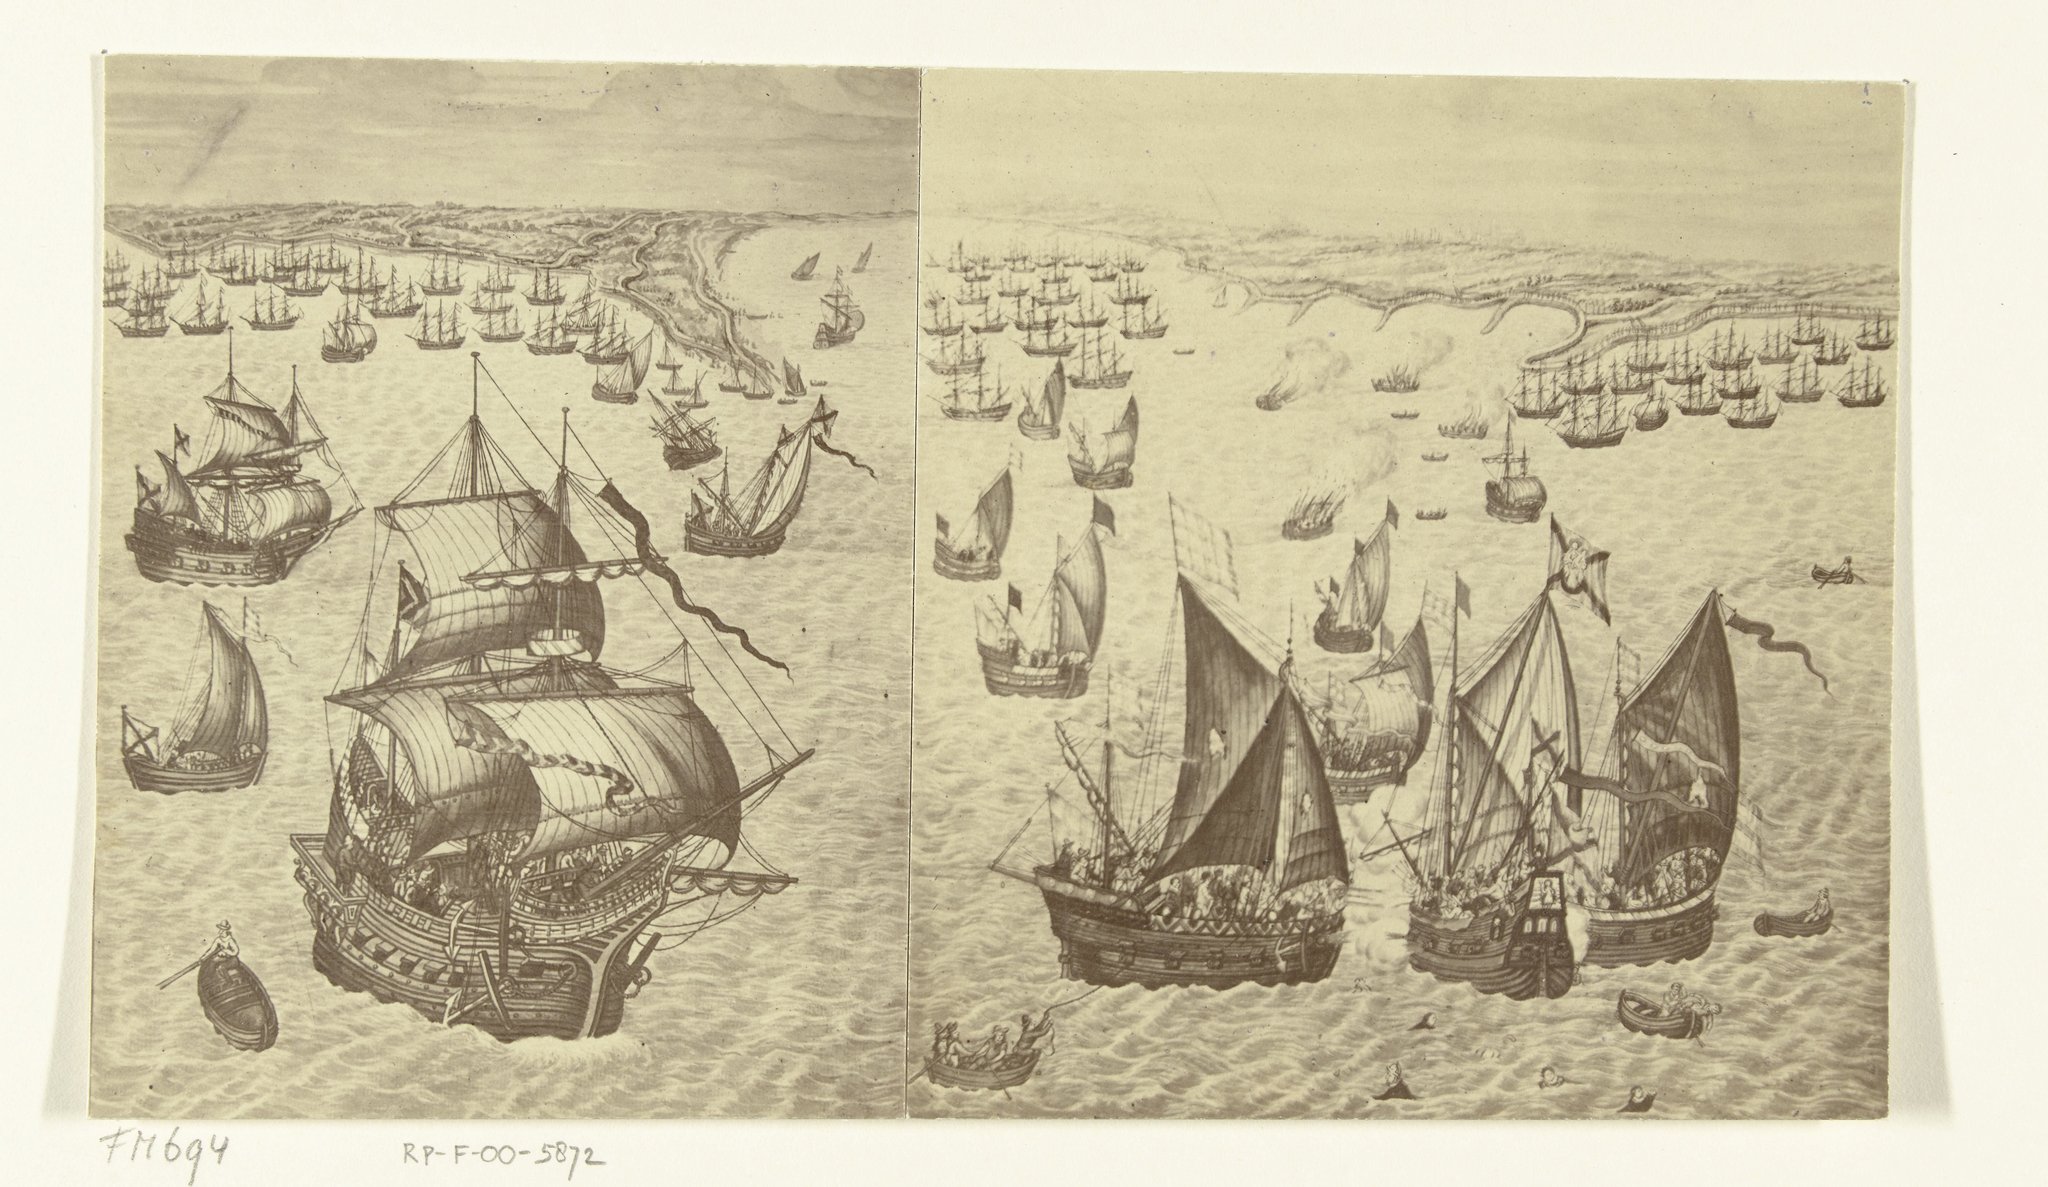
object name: photograph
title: Wandtapijt met de schermutselingen bij Den Haak, 1572-1573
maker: j. v.d. graft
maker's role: fotograaf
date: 1863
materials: photographic support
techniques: albumen print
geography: middelburg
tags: battle (+ naval force), tapestry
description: Foto van de twee wandtapijten geweven door Hendrick de Maecht te Middelburg naar ontwerp van Hendrick Vroom te Haarlem en patroonschilder Huybrecht Leyniers te Dordrecht in de jaren 1600-1603. Het tapijt bevindt zich in de collectie van het Zeeuws Museum te Middelburg. Het onderwerp van deze tapijten betreft niet de verdrijving van de Spaanse vloot die het belegerde Middelburg wil ontzetten, 10 oktober 1575, zoals aangegeven in Muller.